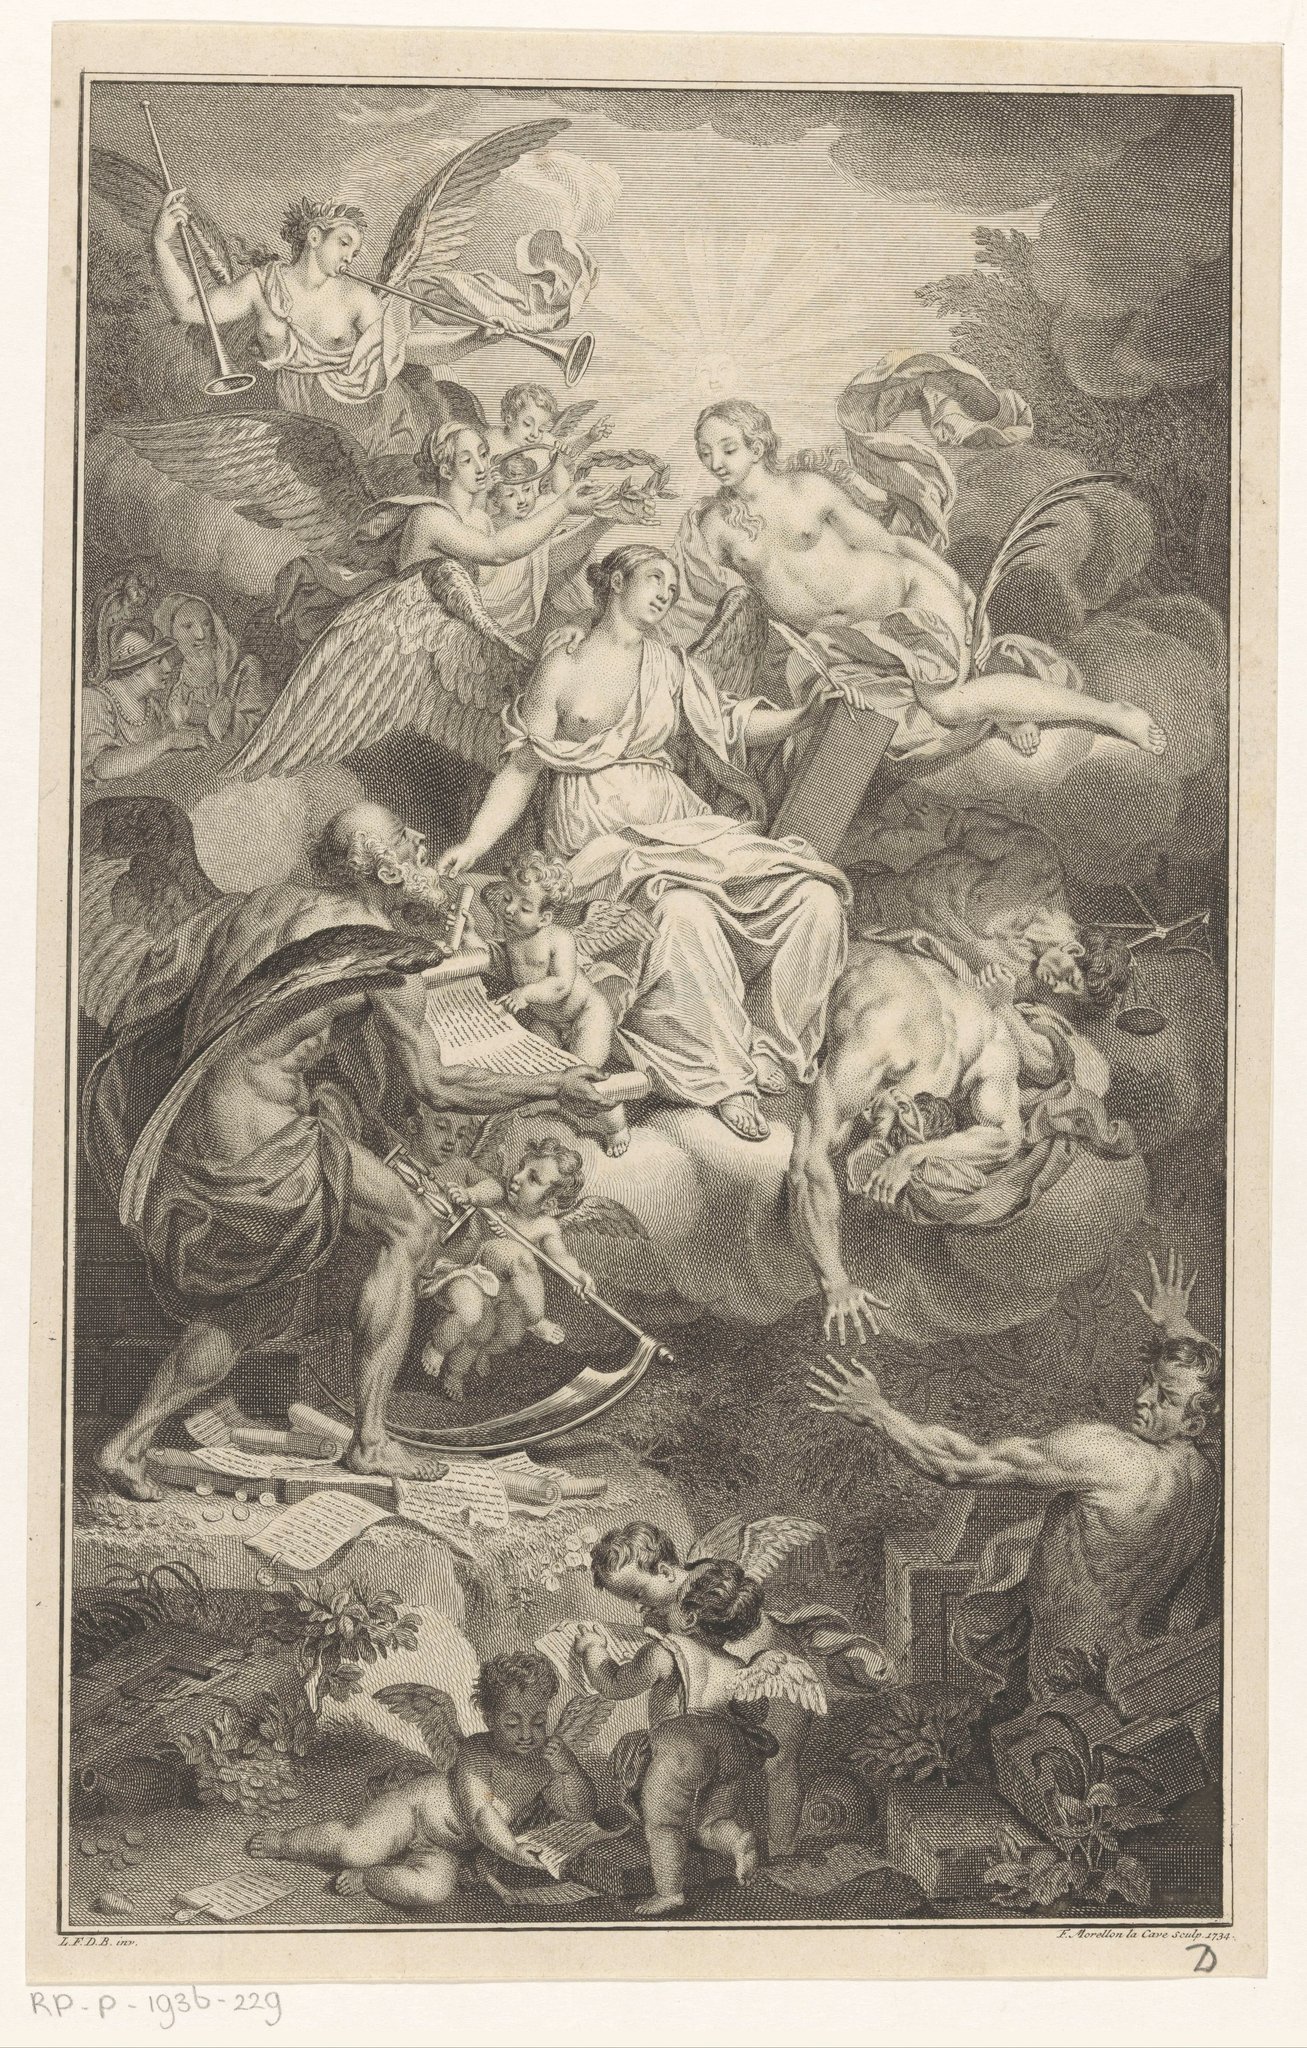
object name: titelblad, titelpagina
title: Titelpagina voor: Gerard van Loon, Aloude Hollandsche histori der keyzeren, koningen, hertogen en graaven, 1734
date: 1734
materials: paper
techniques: engraving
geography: the hague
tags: 'historia'; 'historia' (ripa), fame; 'fama', 'fama buona', 'fama chiara' (ripa), father time, man with wings and scythe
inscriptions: collector's mark: Lugt 2760, collector's mark: Lugt 2228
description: Titelpagina voor: Loon, Gerard van. Aloude Hollandsche histori der keyzeren, koningen, hertogen en graaven; welken, sedert de komst der Batavieren in het thans genaamde Holland, tot de herstelling van 'sgraaven Florents den eerstens zoon, aldaar het hooggebied gehad hebben. Den Haag: Hondt, Pieter de, 1734.